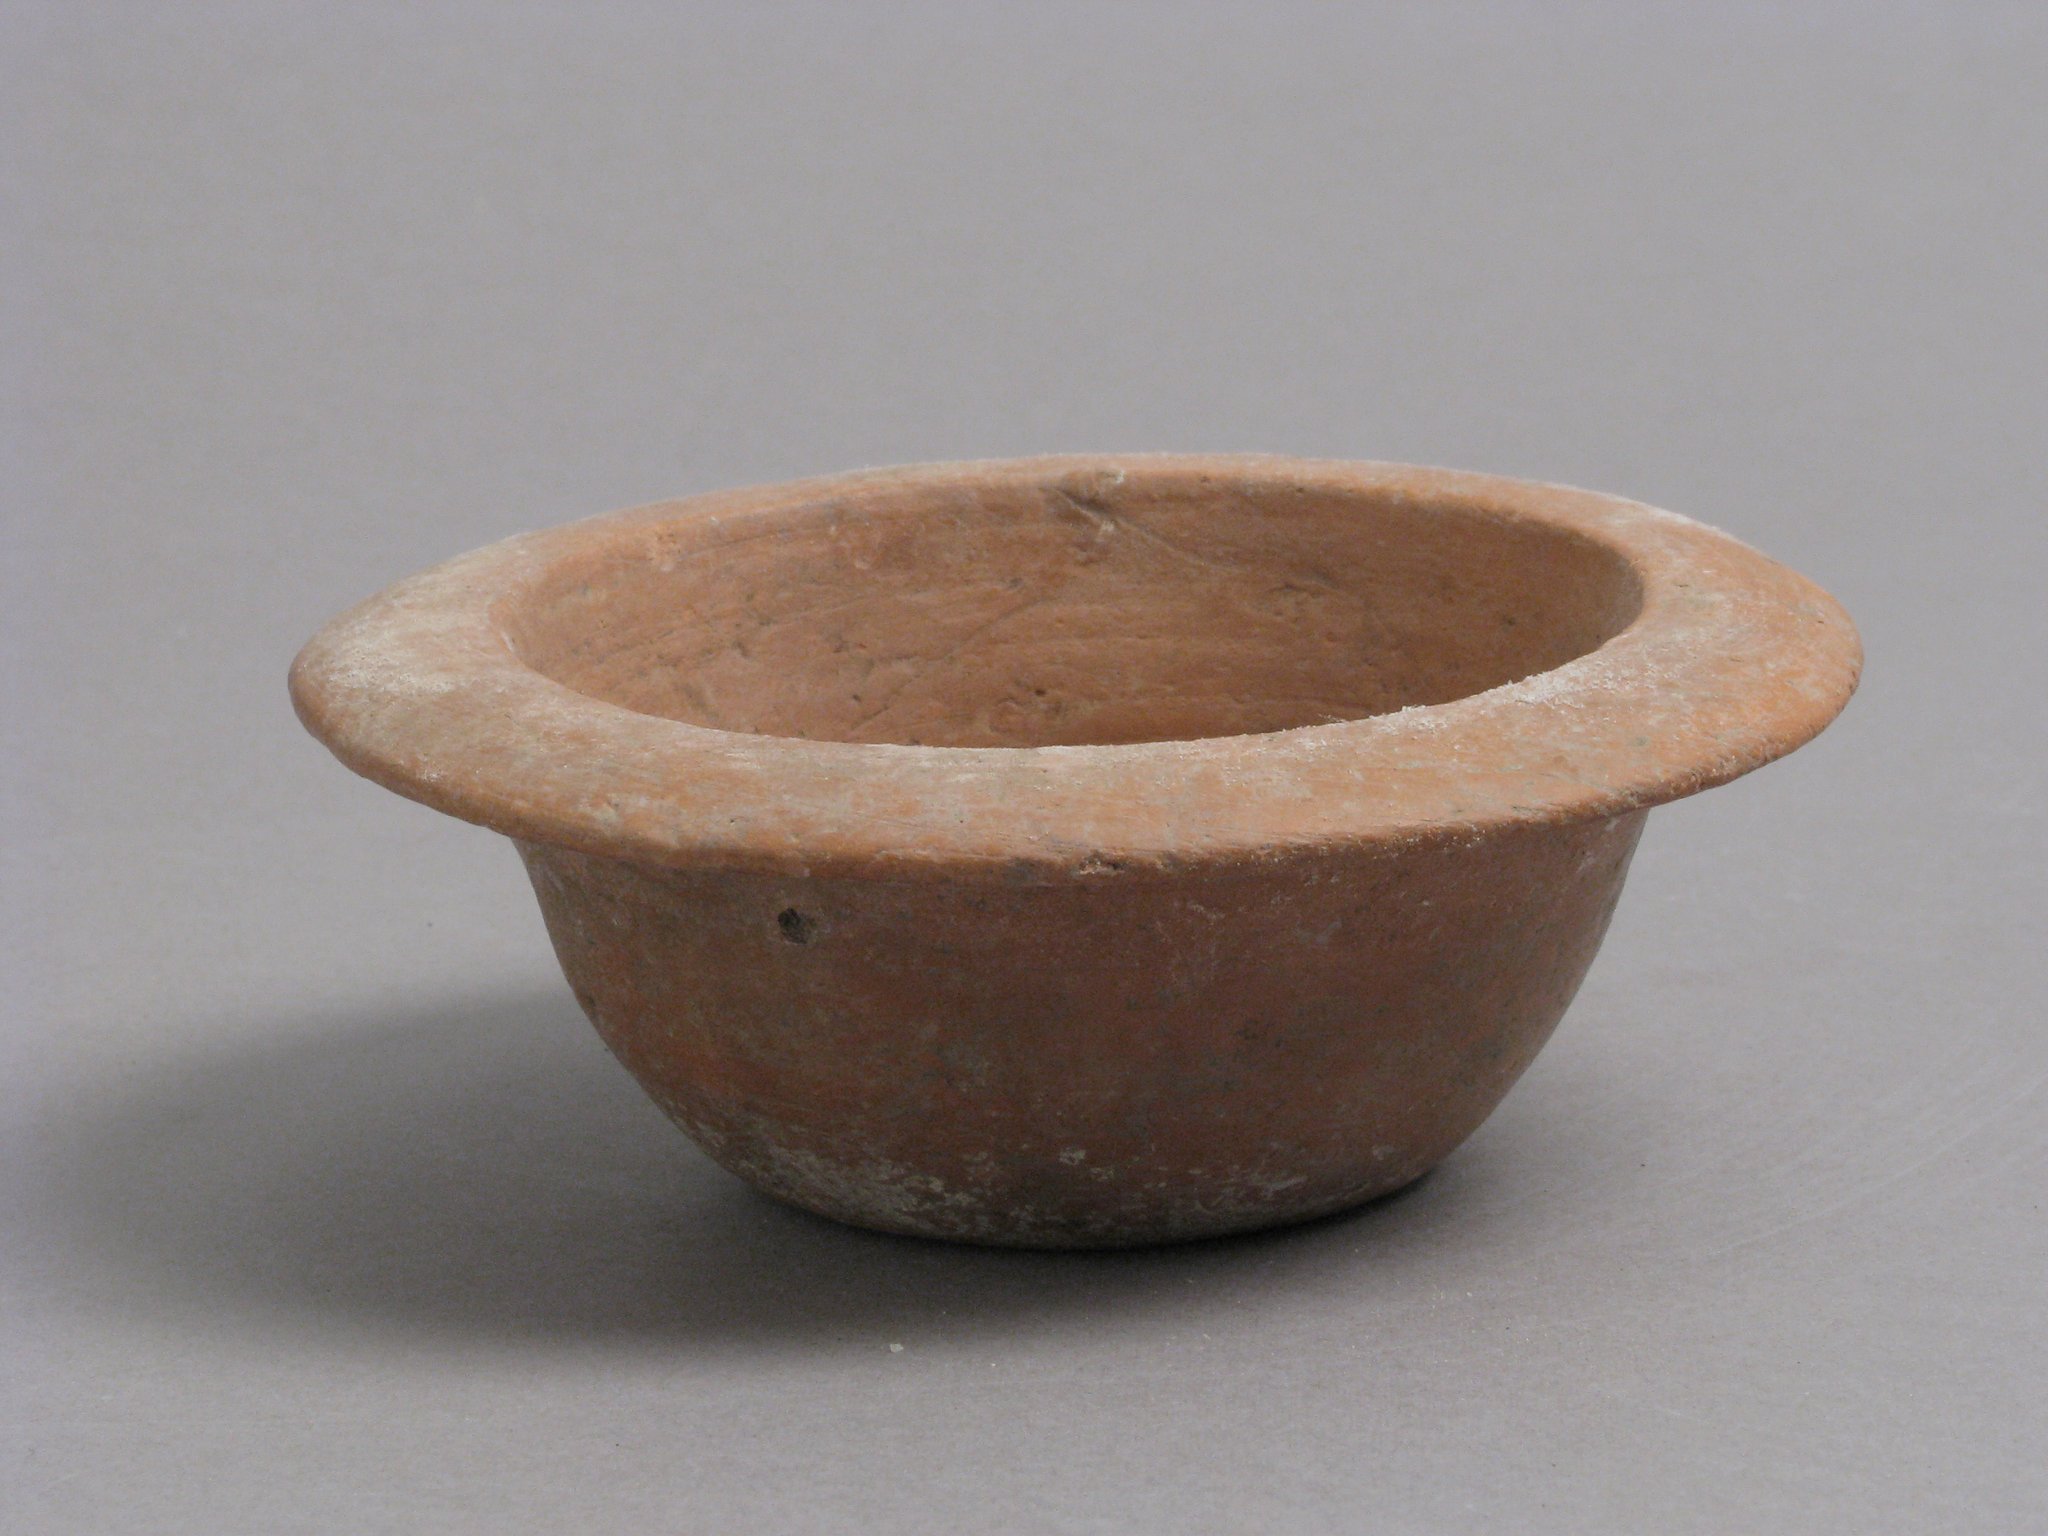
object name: bowl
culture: coptic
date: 301-700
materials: earthenware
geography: egypt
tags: bowls